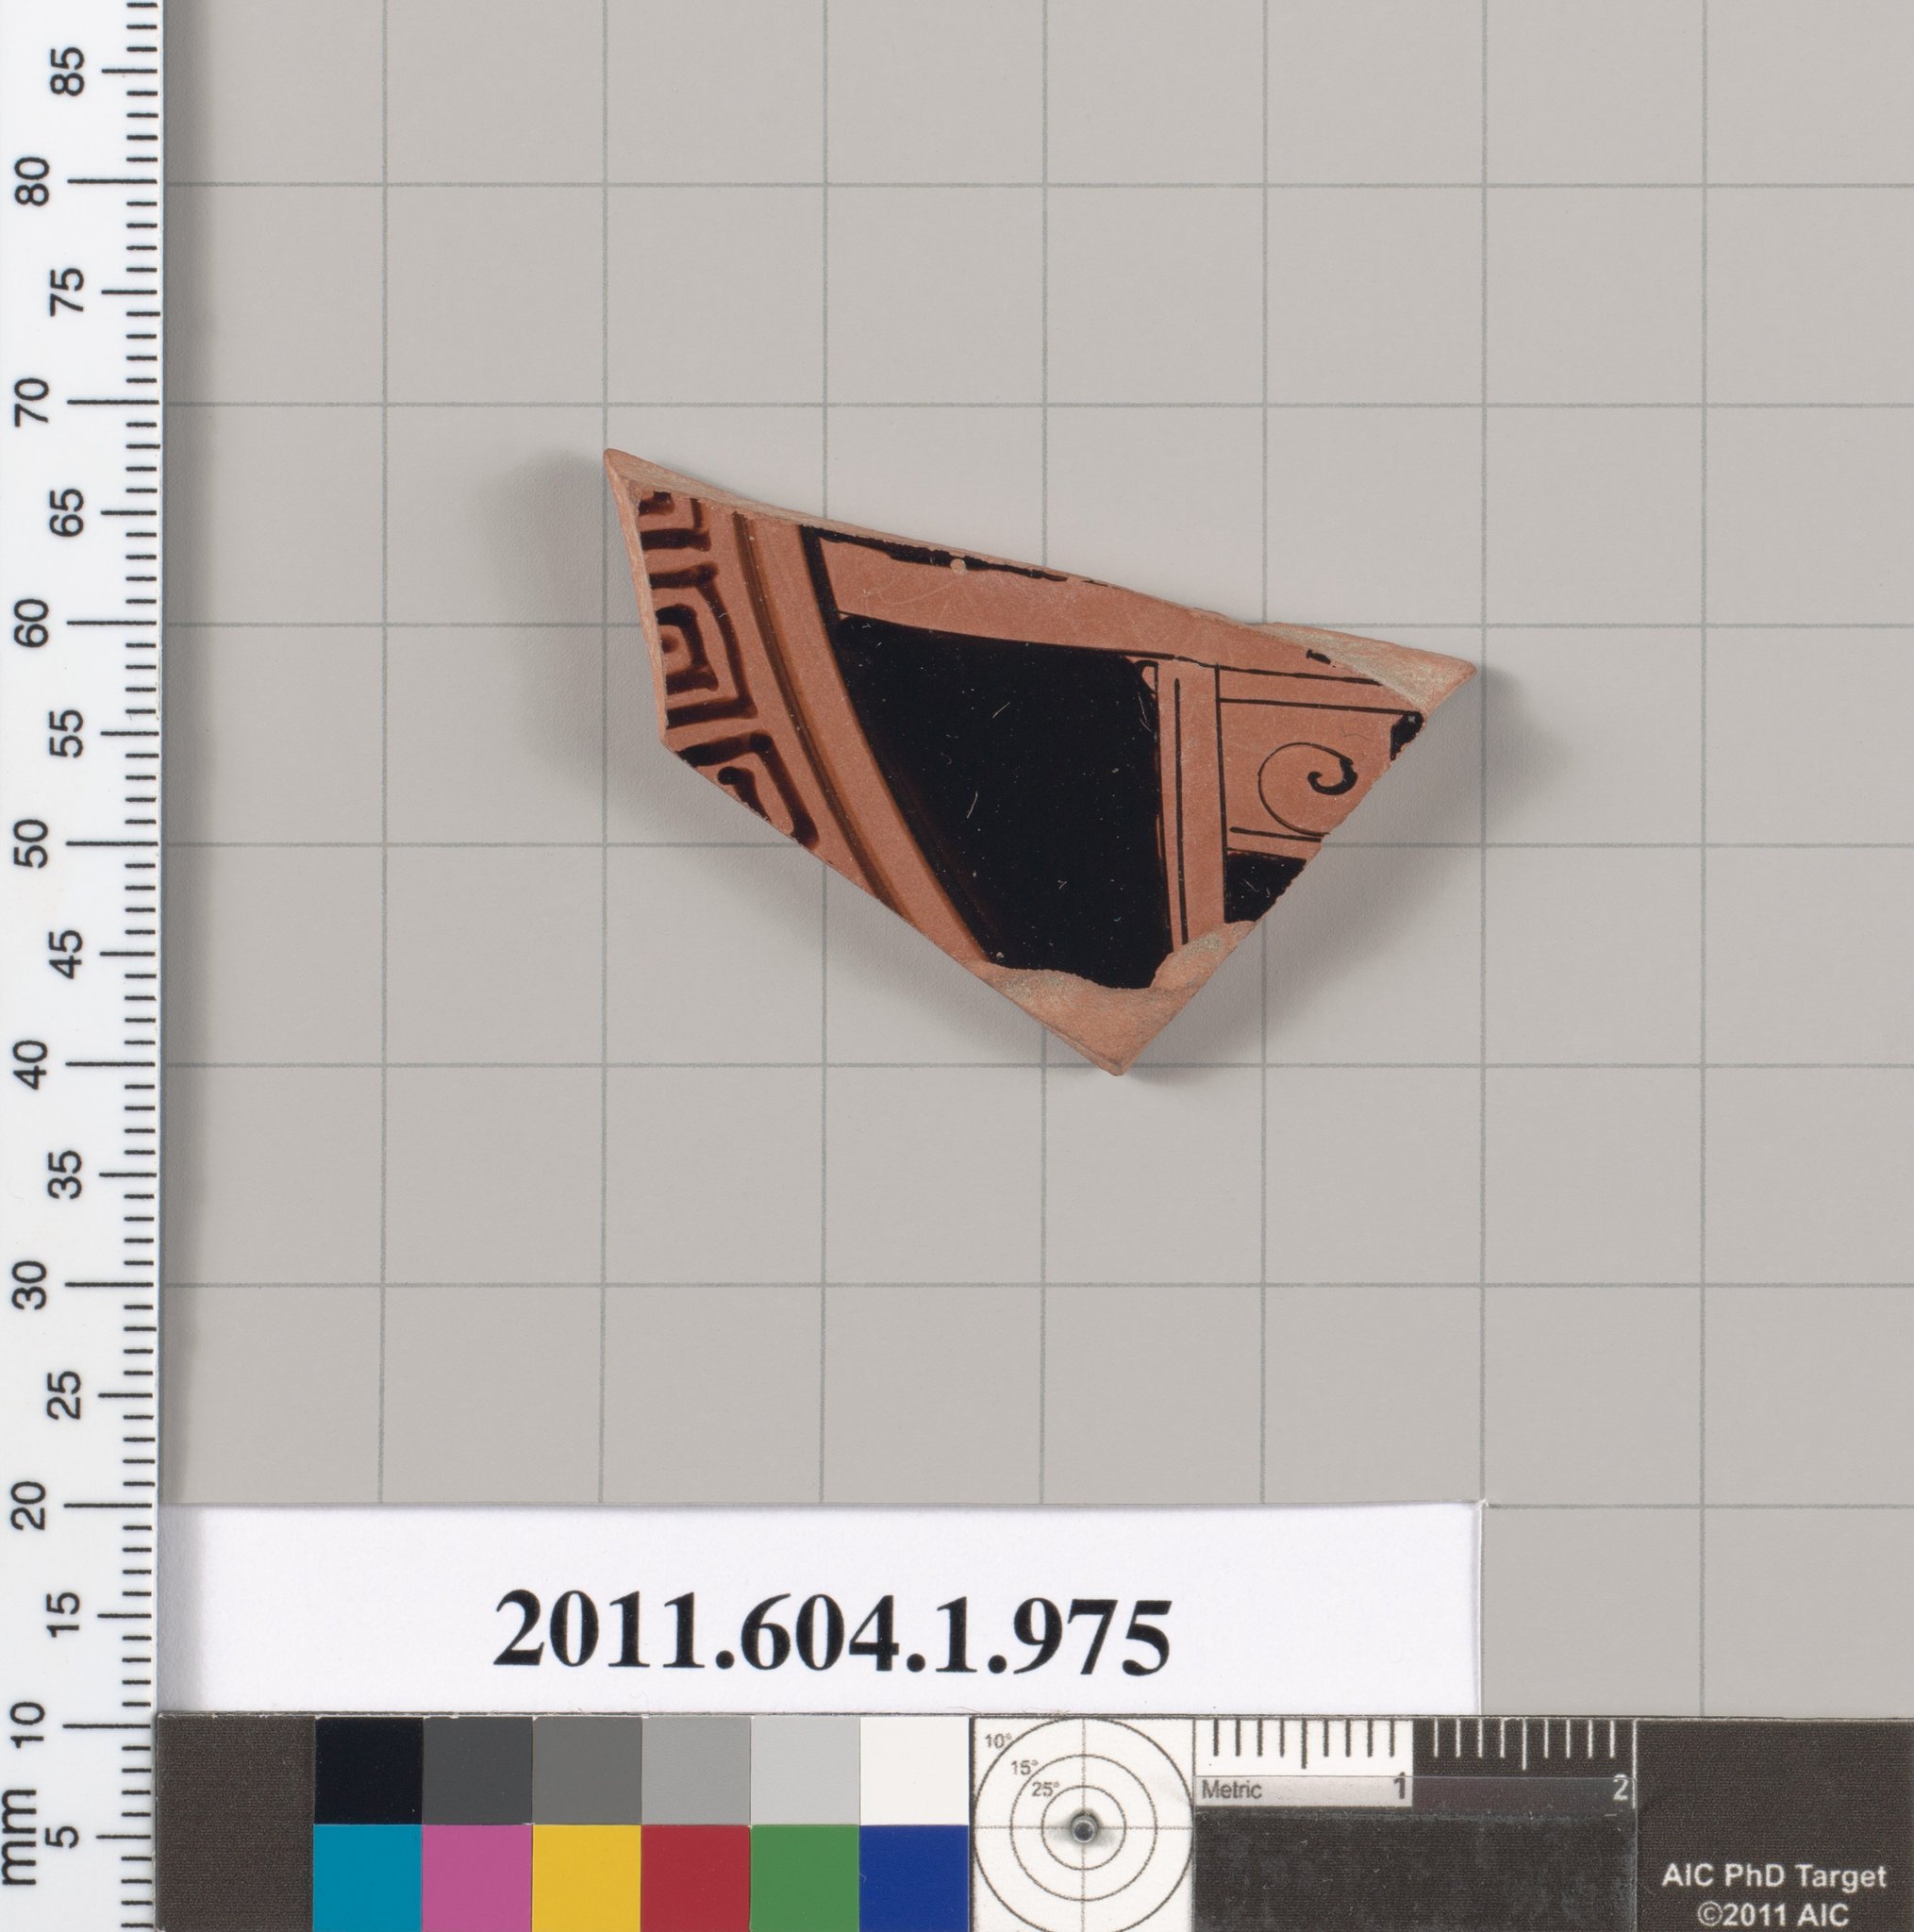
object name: kylix fragment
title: Terracotta fragment of a kylix (drinking cup)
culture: greek, attic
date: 490-480 BCE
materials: terracotta